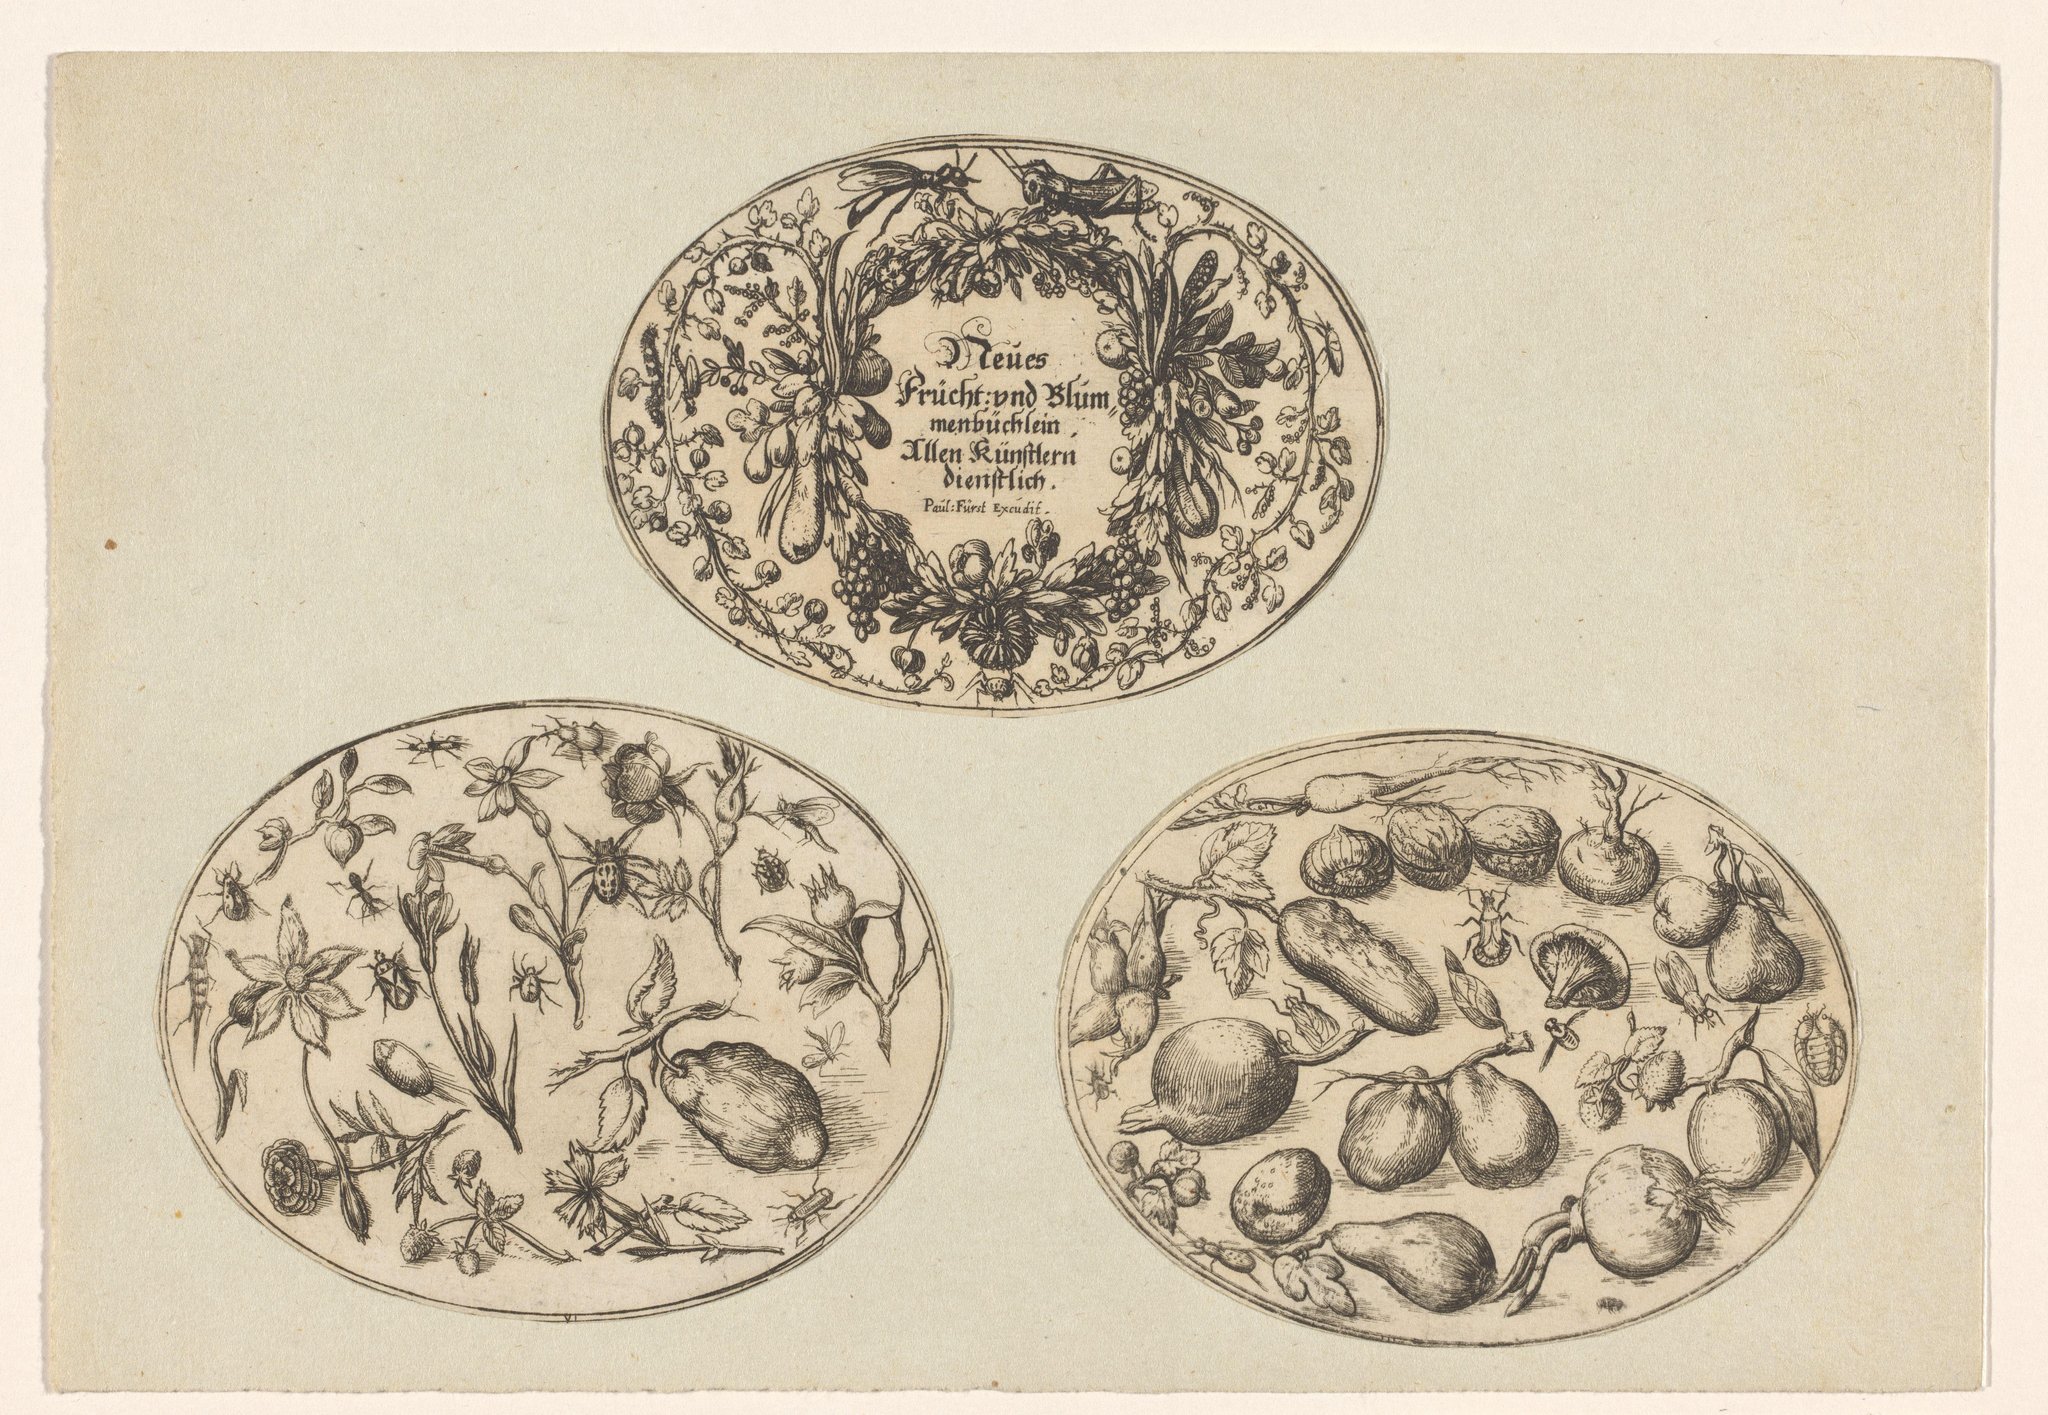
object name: titelprent, frontispice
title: Neues Frücht-vnd Blumenbüchlein. Allen Künstlern dienstlich.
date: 1650-1666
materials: paper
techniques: etching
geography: nuremberg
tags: ornament derived from animal forms, insects, ornament derived from plant forms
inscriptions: collector's mark: Lugt 2760, collector's mark: Lugt 2228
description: Paul Fürst, Neues Frücht-vnd Blumenbüchlein. Allen Künstlern dienstlich. Een van zeven prenten (RP-P-2020-235 t/m 241), inclusief titelblad uit een reeks van acht met weergaven van bloemen, vruchten, noten paddenstoelen en insecten.